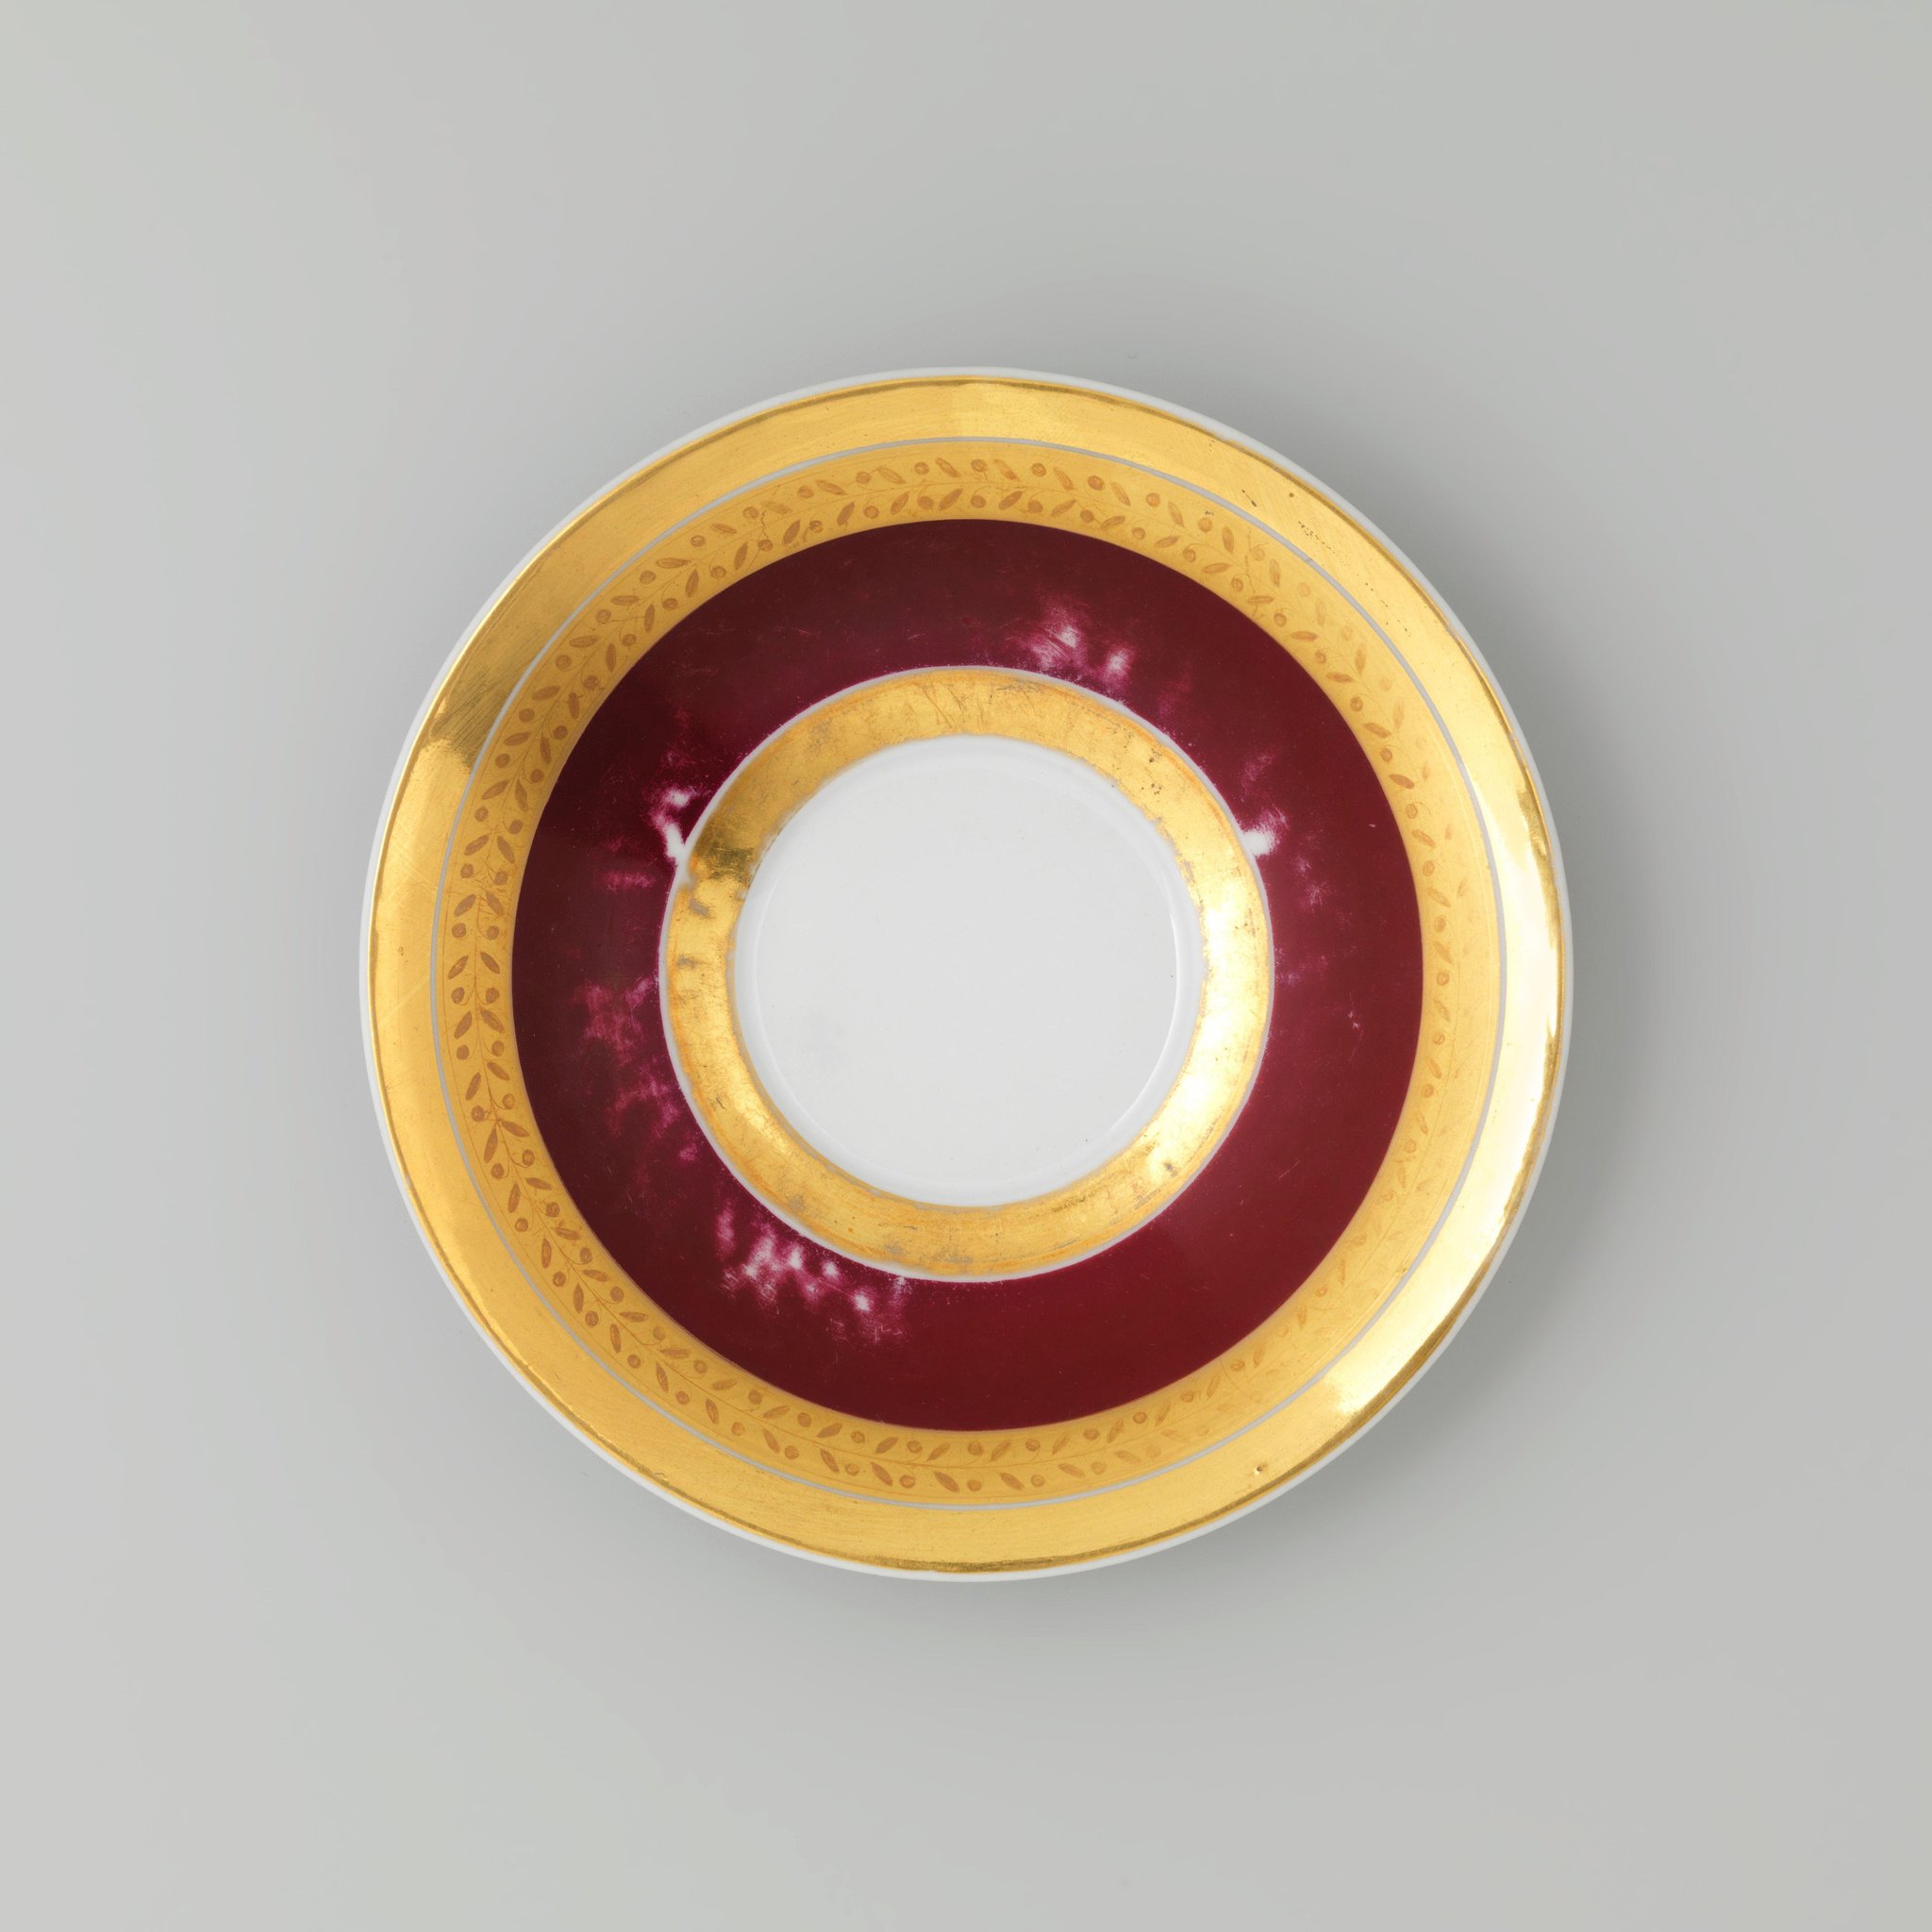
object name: service set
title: Saucer with gold borders on a red ground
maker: Anonymous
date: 1800-1824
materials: glaze, gold, paint, porcelain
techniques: firing, forming, gilding, turning, vitrification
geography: france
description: Schotel van porselein, bedekt op het glazuur met rood en goud. De wand en rand zijn bedekt met banden van rood en goud, waarbij op de rand éé een bloemrank heeft. Gouden lijn op de voet. Empire.